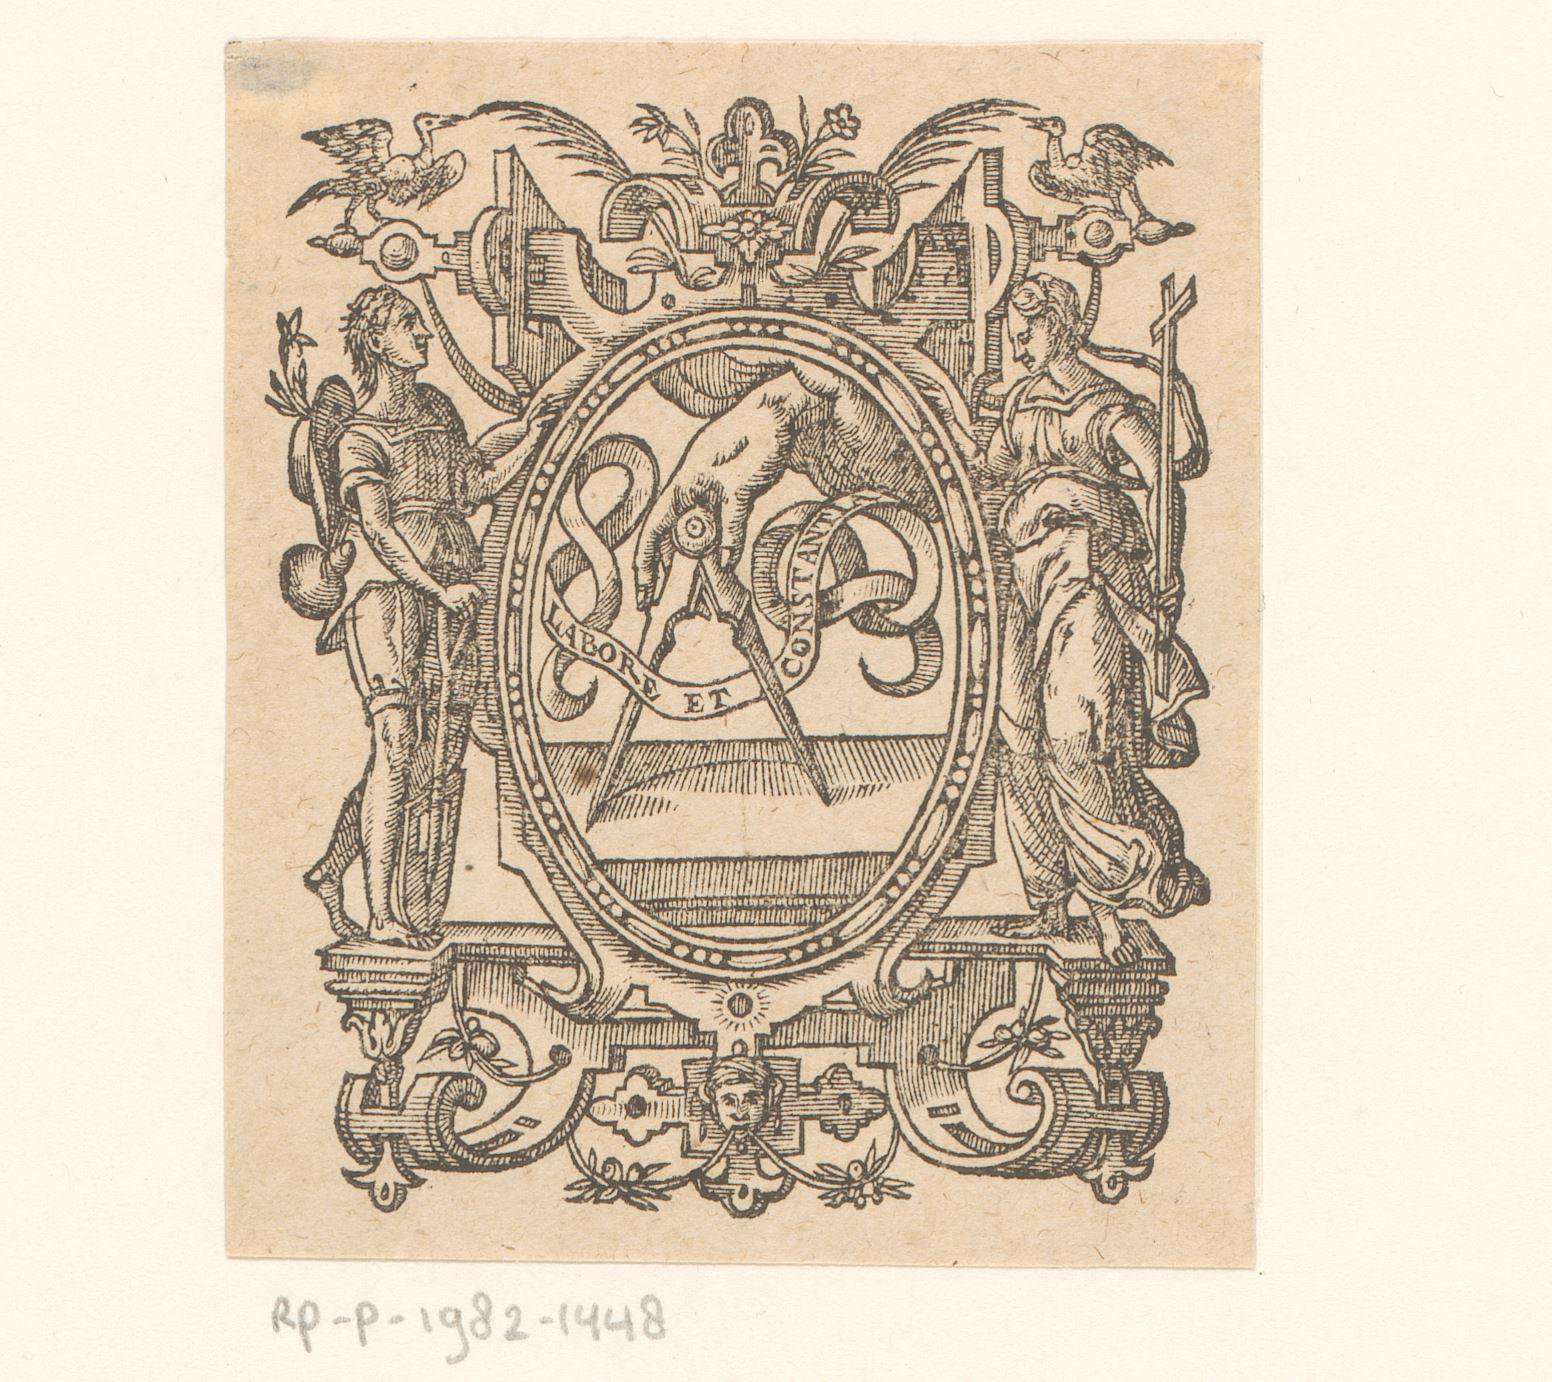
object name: printer's mark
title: Labore et Constantia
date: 1561-1620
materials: paper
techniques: woodcut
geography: antwerp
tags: compasses, device (trade-mark of printer or publisher), constancy, tenacity; 'costanza', 'tenacità' (ripa), abstract ideas and concepts (+ personification)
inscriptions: collector's mark: Lugt 2228, collector's mark: Lugt 2760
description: Drukkersmerk voor de drukkerij Plantijn te Antwerpen. In het midden een hand met een passer, een verwijzing naar het uithangbord 'De Gulden Passer'. Om de passer krult een banderol met het motto 'Labore et Constantia'. Hiernaast de personificaties van Labore en Constantia, met schep en crucifix.